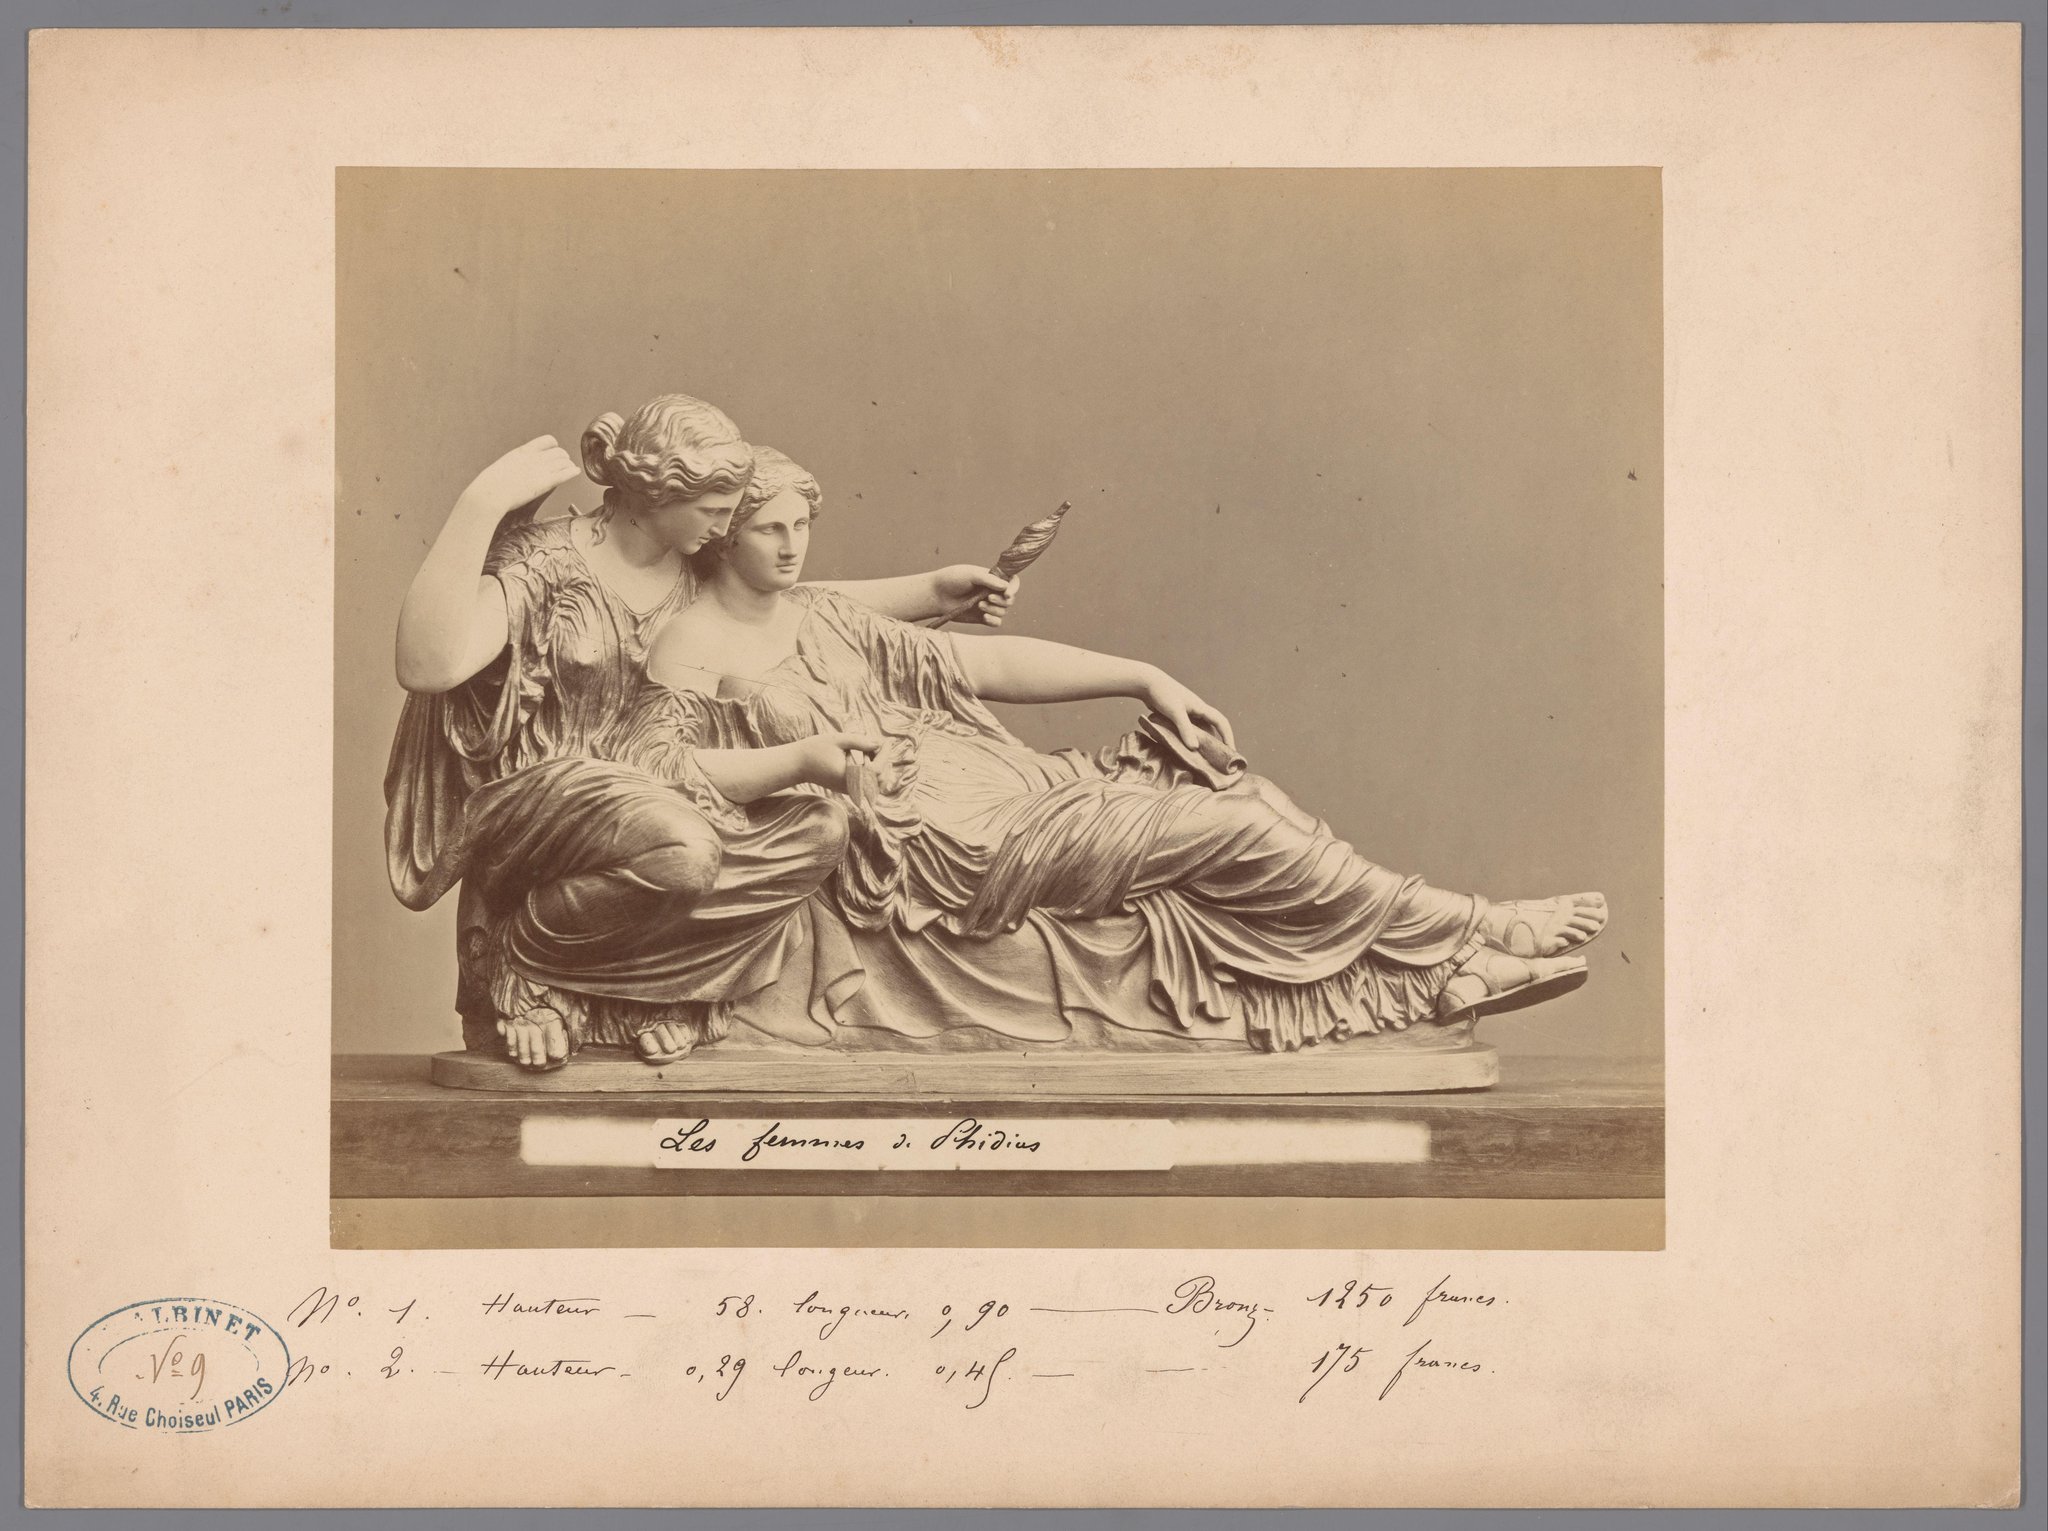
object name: photograph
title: Beeld of afgietsel van een beeld van twee vrouwen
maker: Anonymous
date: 1850-1900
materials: cardboard, photographic support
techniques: albumen print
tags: adult woman, sculpture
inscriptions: stamp: ‘Albinet/ 4. Rue Choiseul Paris’, inscription: ‘[...]/ Boasberg/ April 84’, number: ‘No. 9’, inscription: ‘No. 1. Hauteur - 58. largeur 0,90 - Bronz- 1250 francs/No. 2. Hauteur - 0,29 largeur 0,11 - 175 francs’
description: Titel handgeschreven met inkt op de foto.